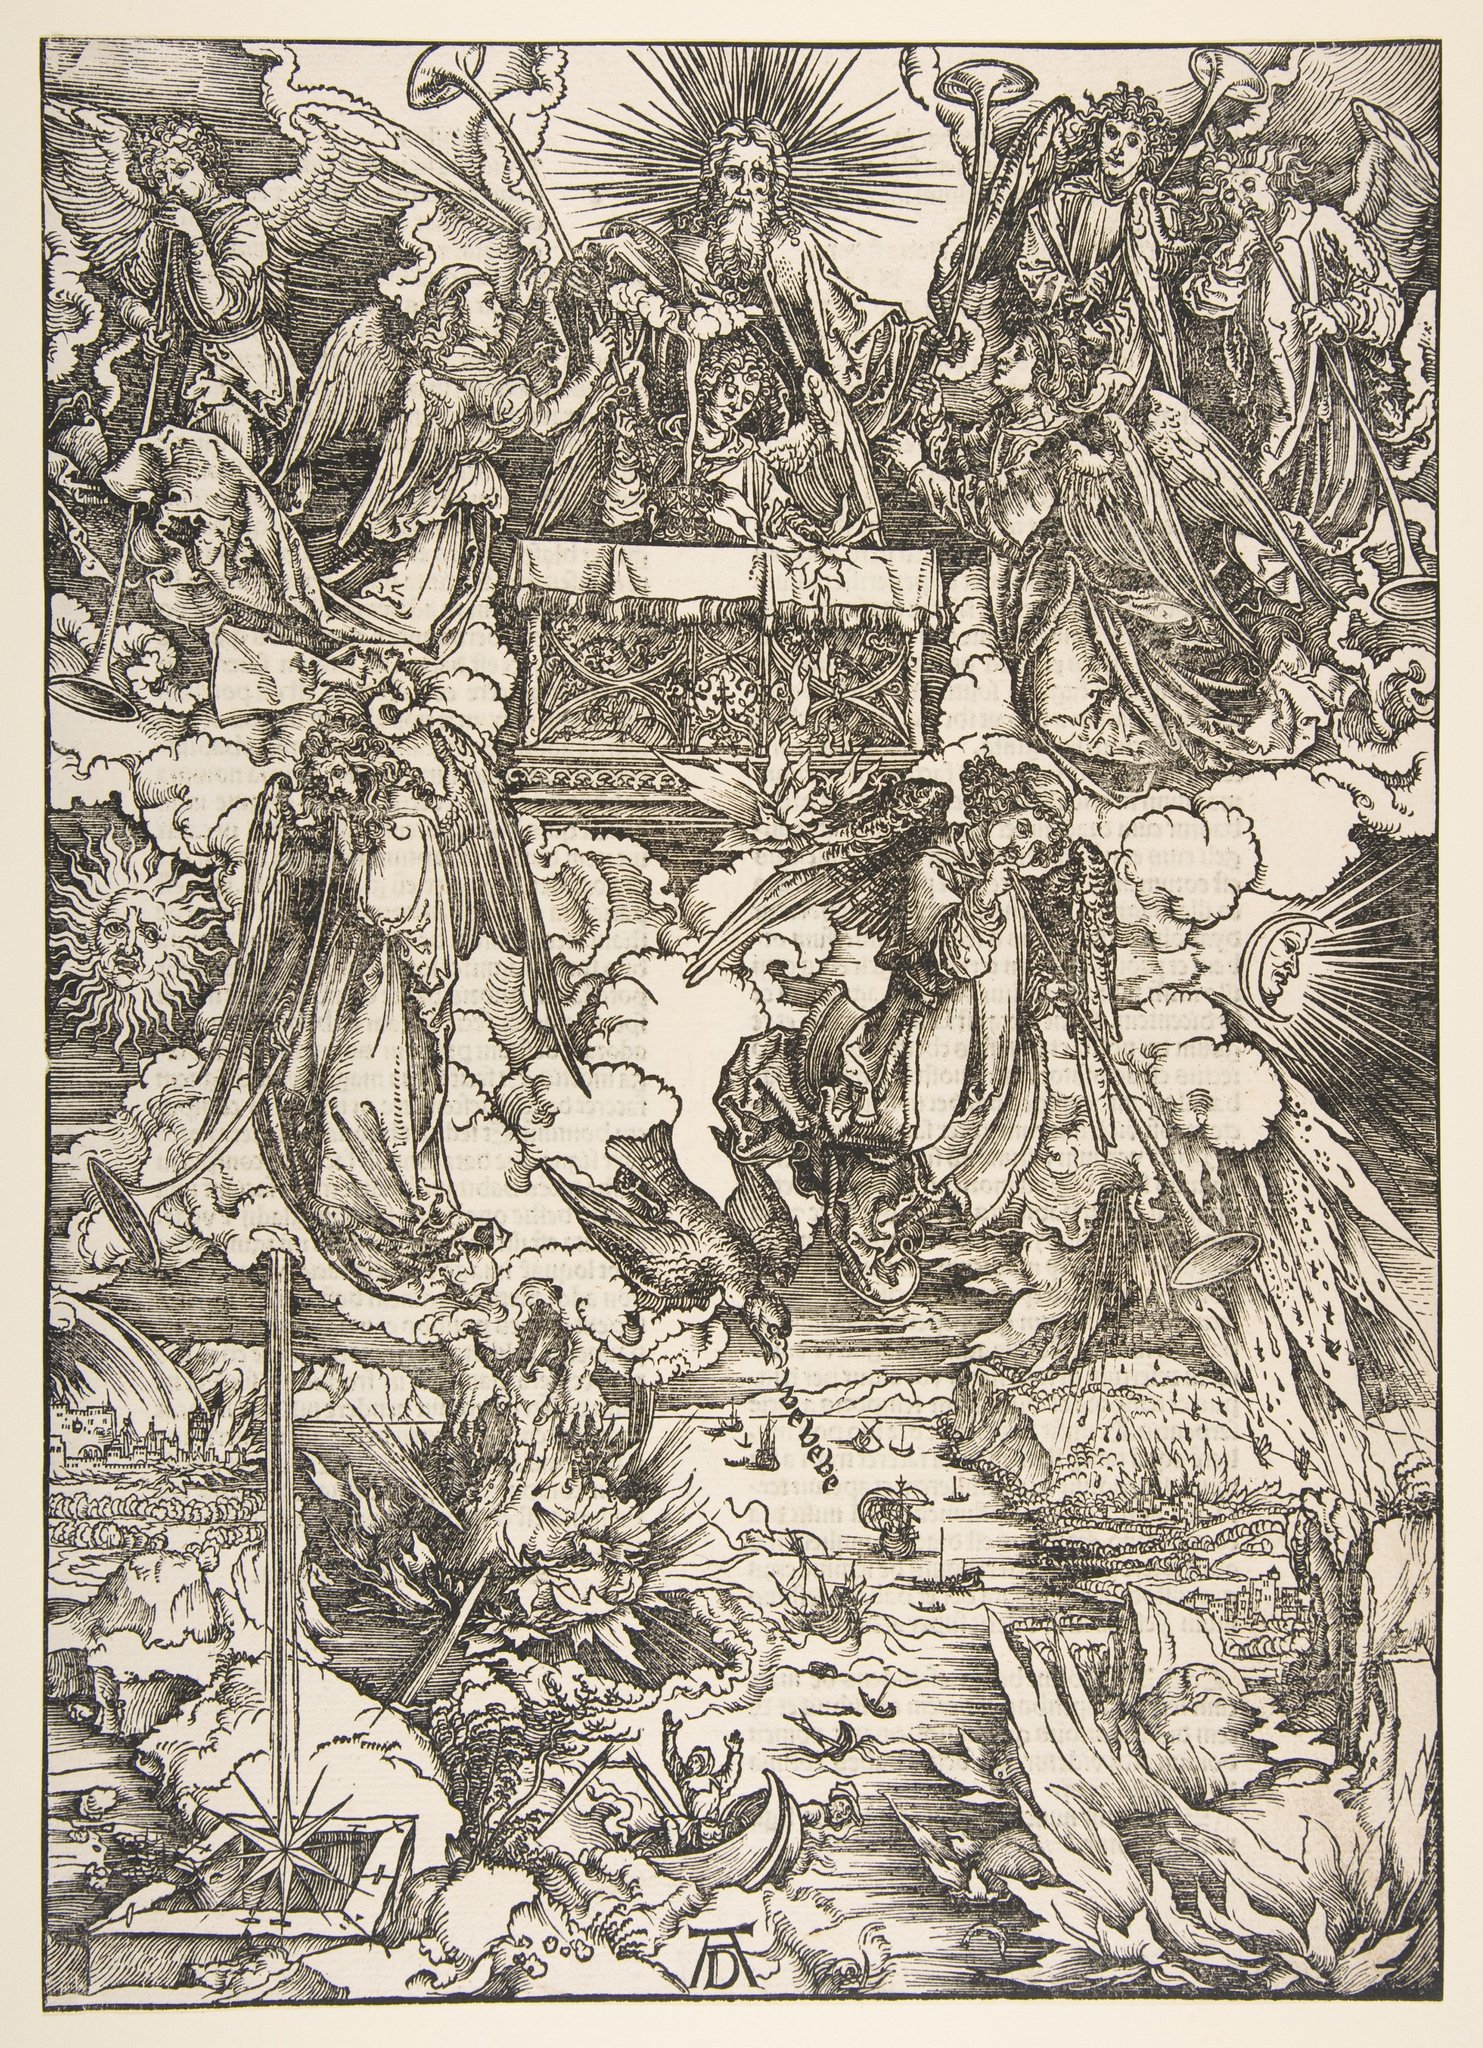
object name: print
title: The Opening of the Seventh Seal, from "The Apocalypse"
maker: albrecht dürer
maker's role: artist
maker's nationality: german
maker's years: 1471-1528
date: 1511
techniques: woodcut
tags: musical instruments,angels,apocalypse